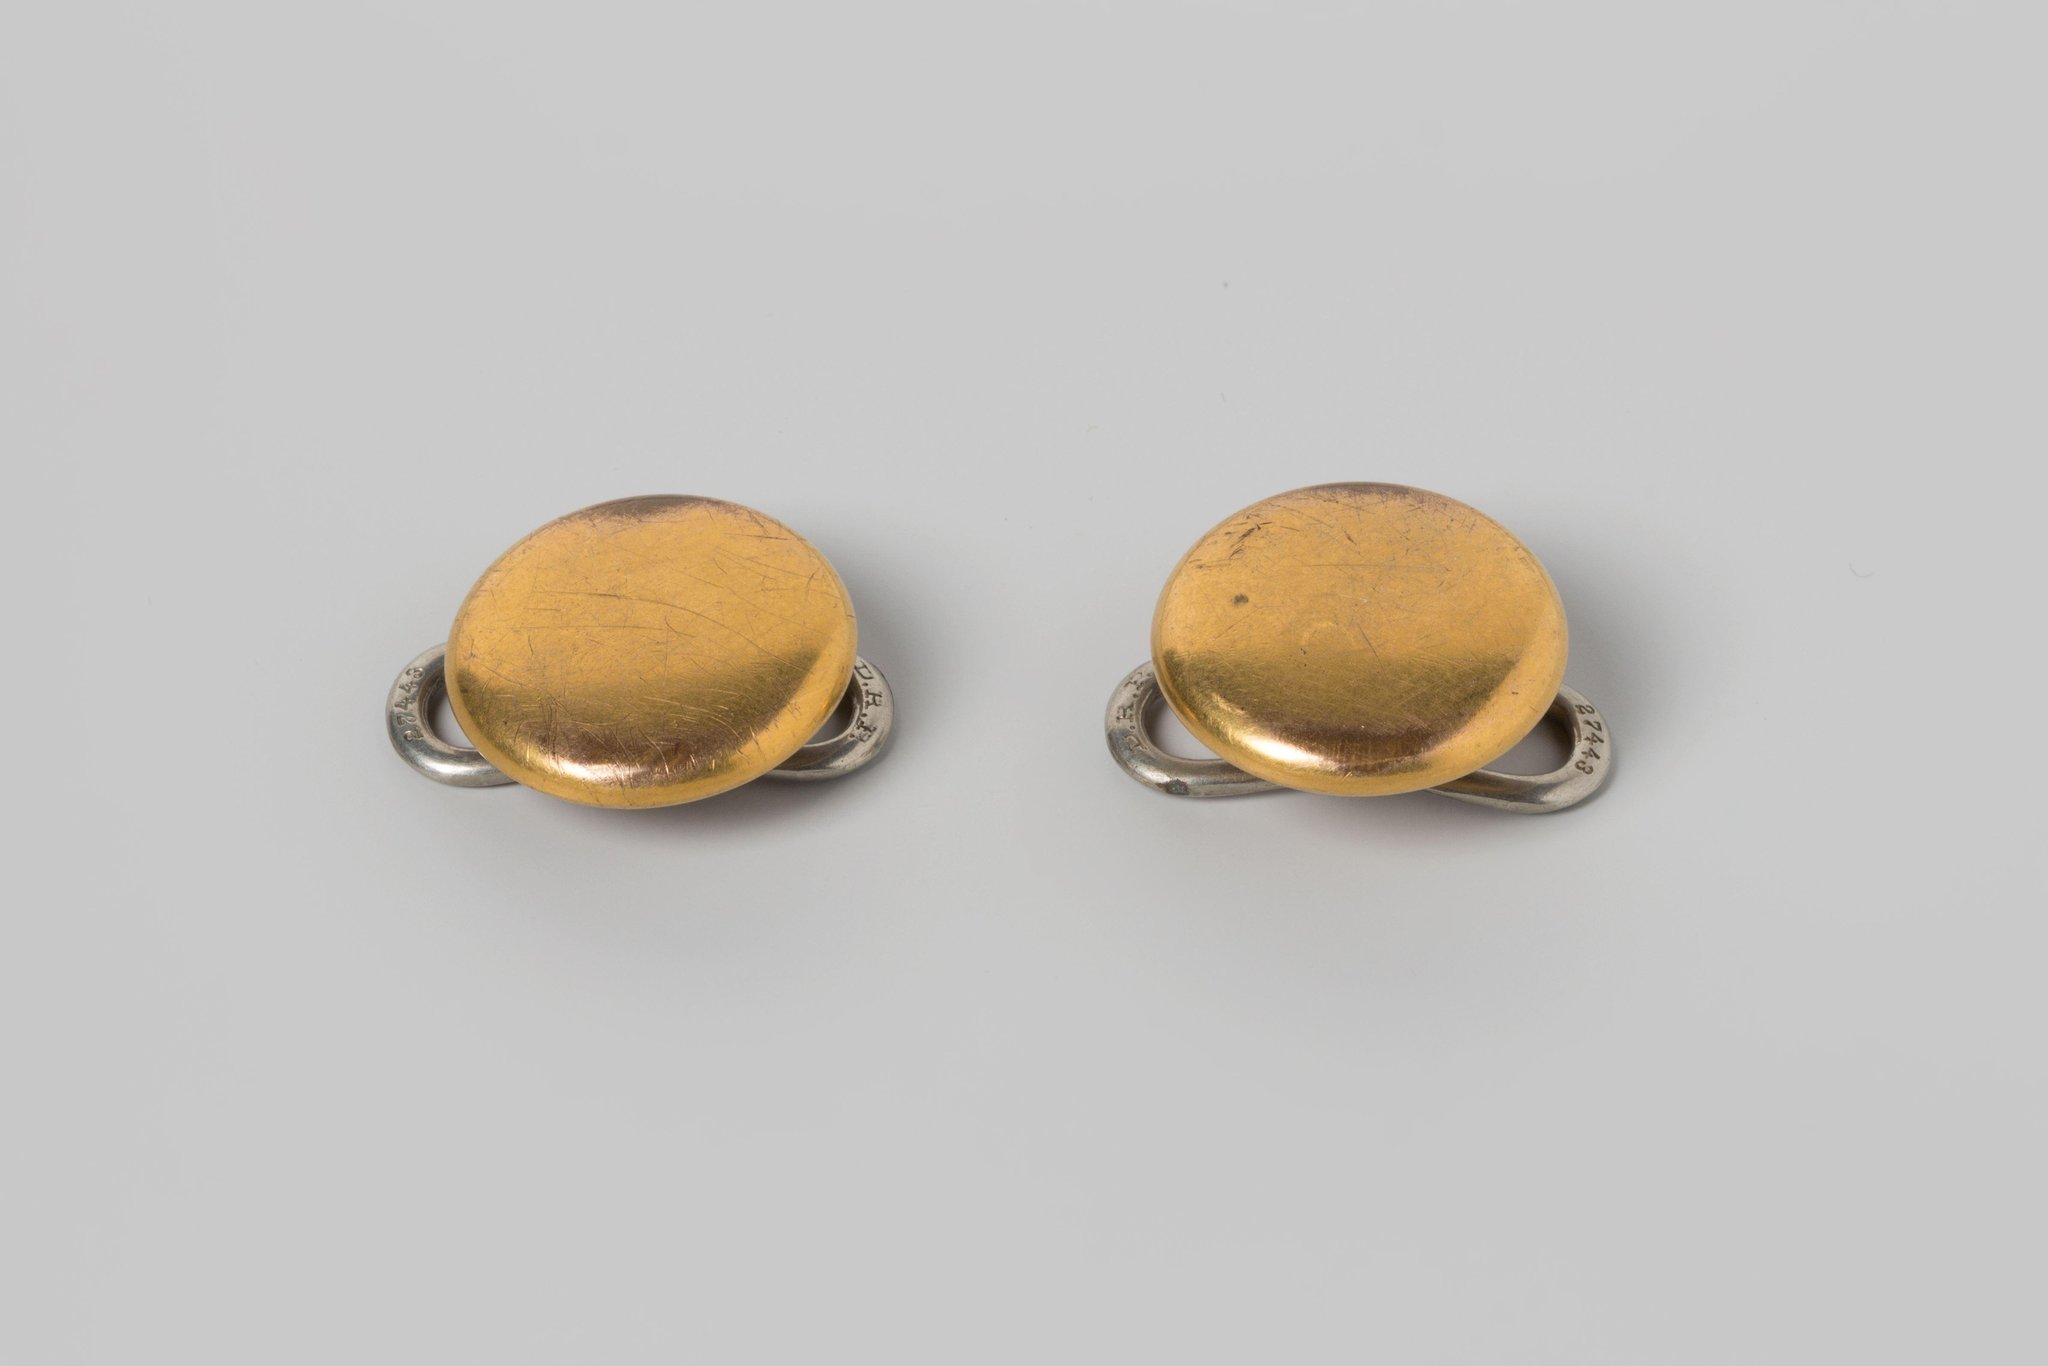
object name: menswear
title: Vestknoop van metaal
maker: Anonymous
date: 1900-1940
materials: metal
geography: netherlands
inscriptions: mark: ‘D.R.F. (?) en 27443’